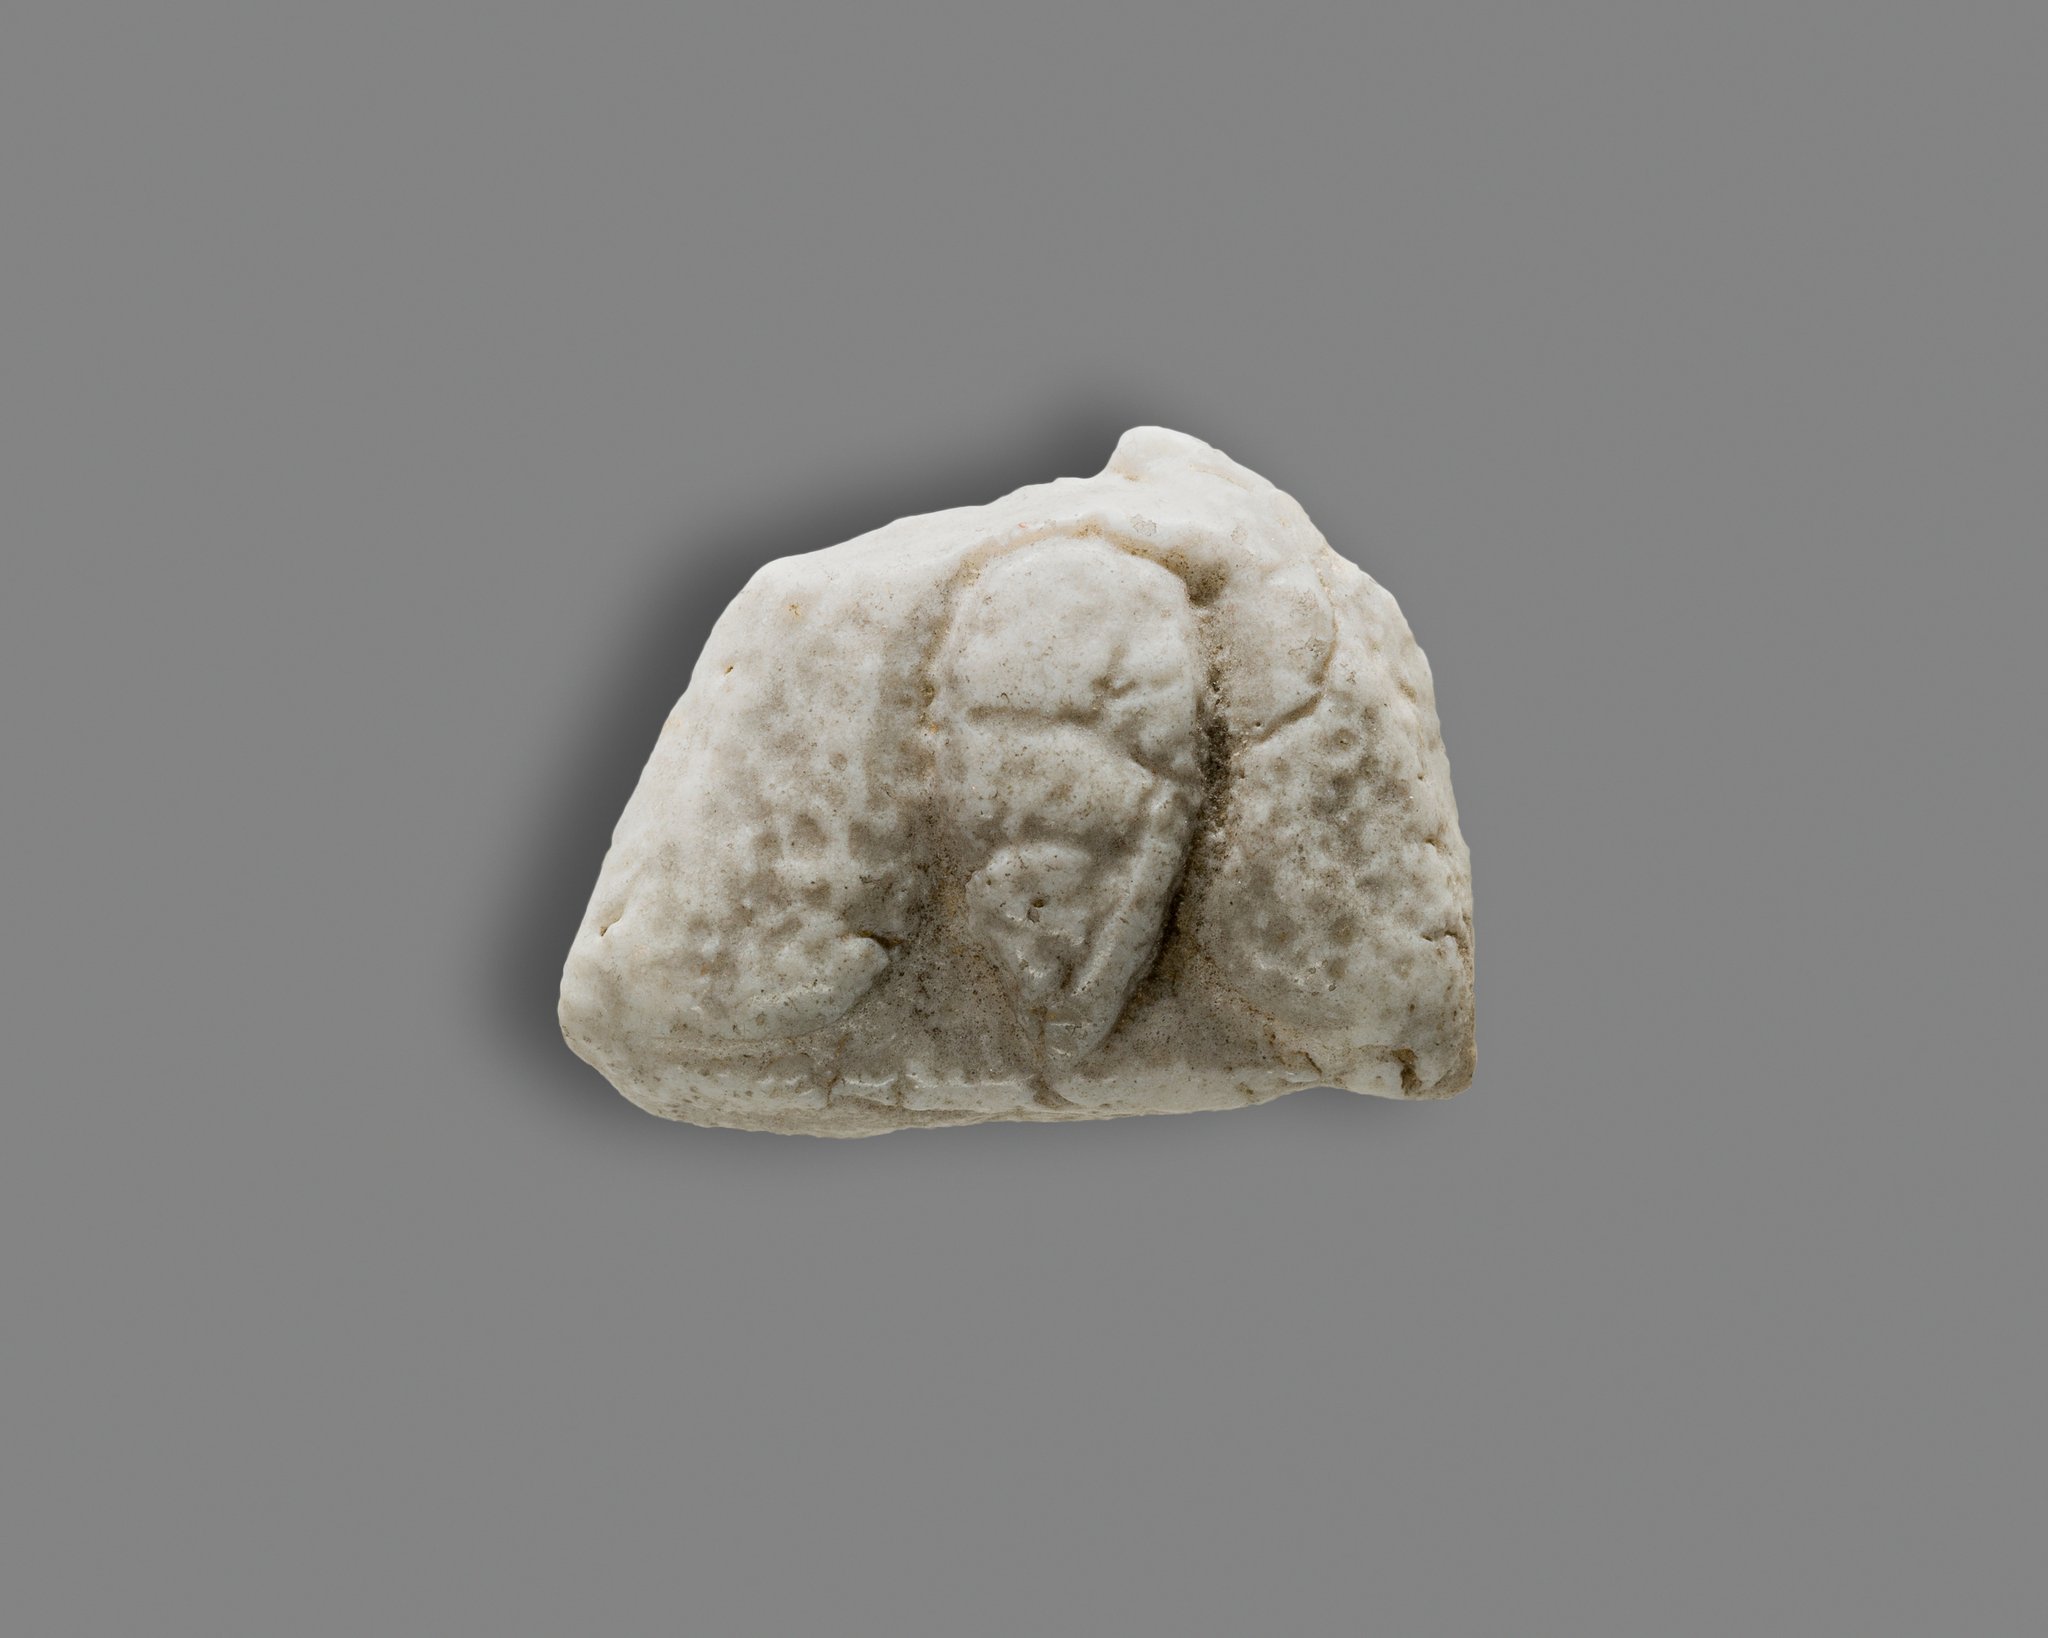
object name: plaque, lotus, foundation deposit, tawosret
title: Foundation Deposit Plaque in the Form of a Lotus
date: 1188-1186 BCE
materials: faience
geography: egypt